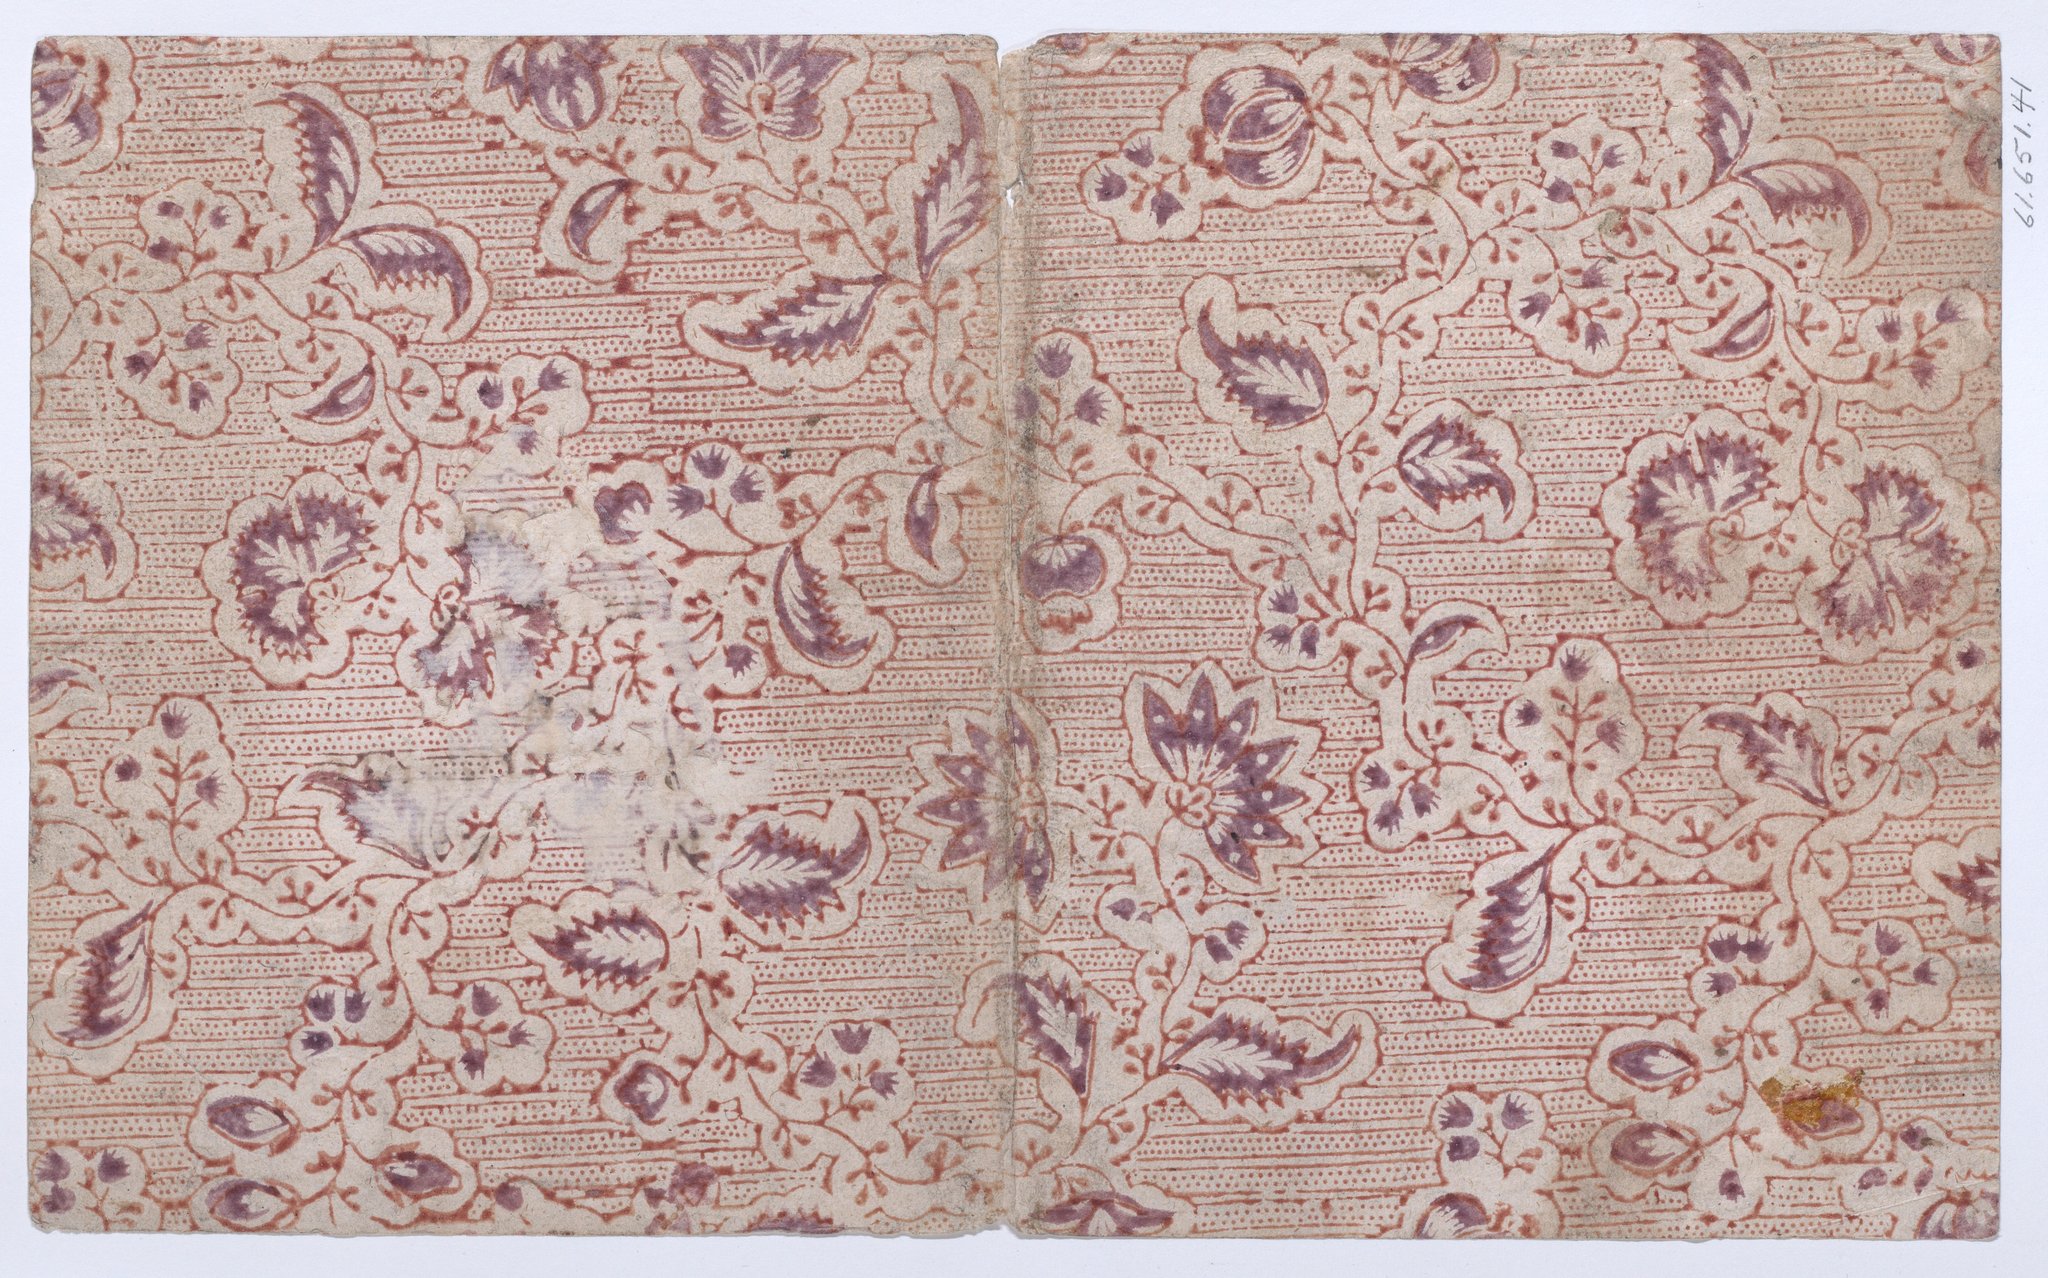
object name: print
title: Book cover with overall paisley, dot, and stripe pattern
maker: Anonymous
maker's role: artist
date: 1801-1900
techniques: relief print